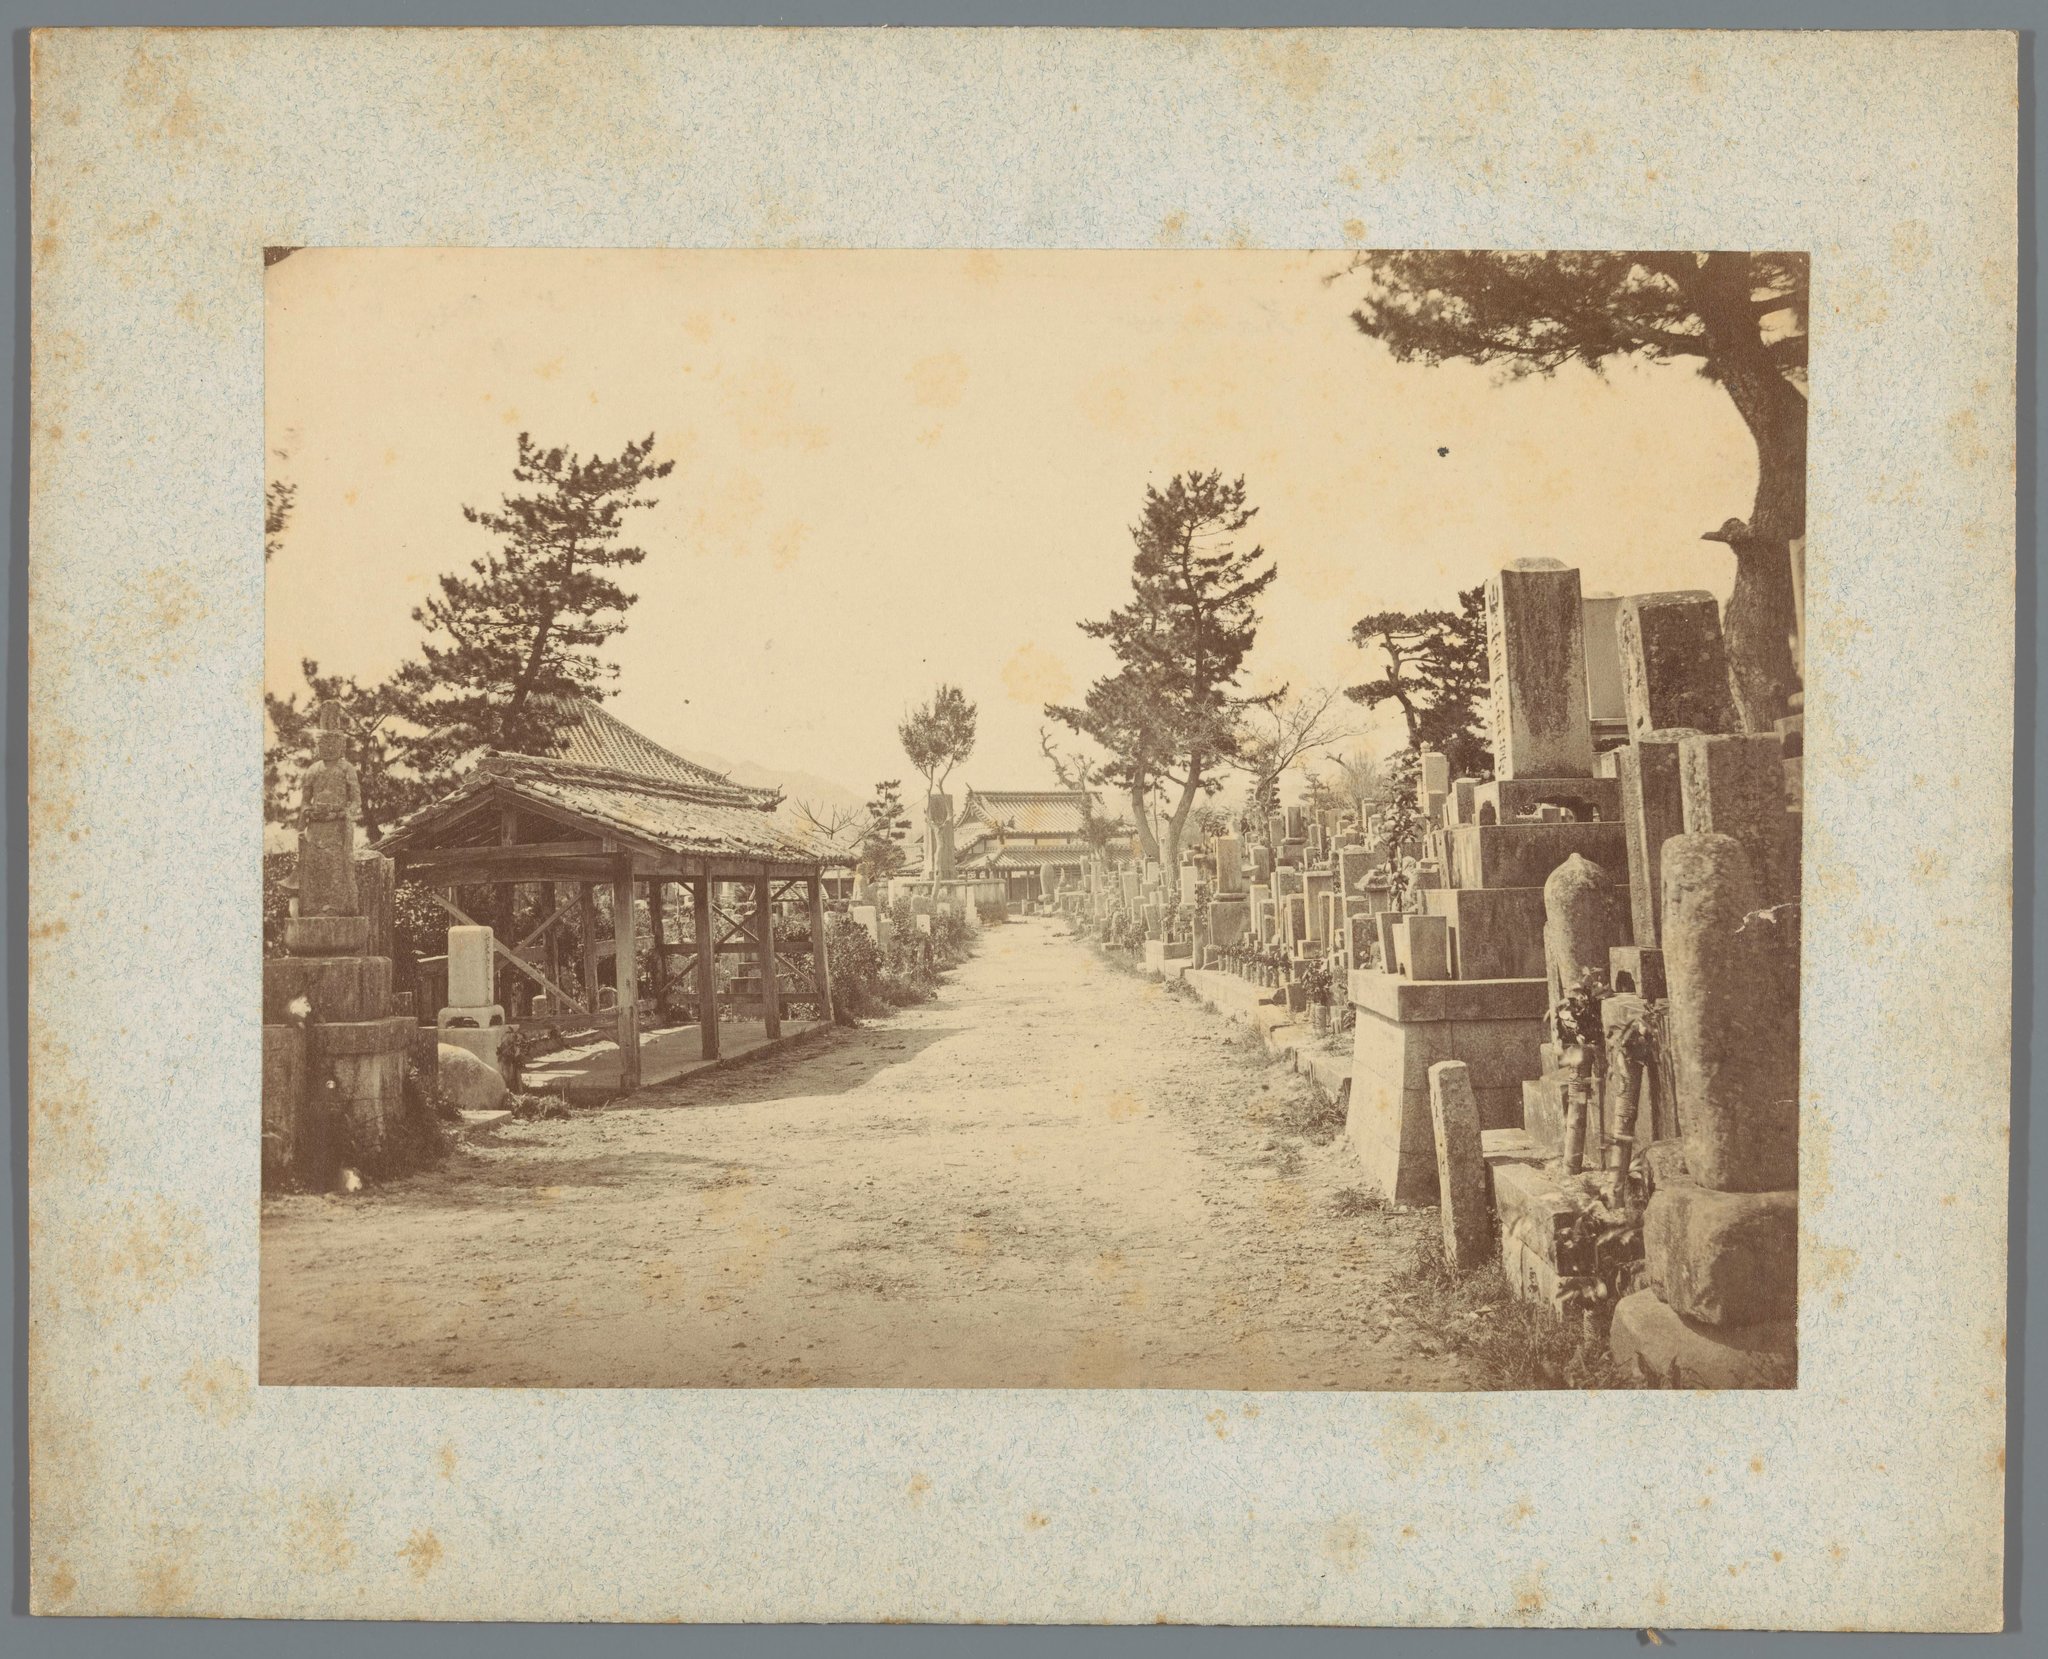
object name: photograph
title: Begraafplaats, vermoedelijk in Japan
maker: Anonymous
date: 1875-1900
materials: cardboard, photographic support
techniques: albumen print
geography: japan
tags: trees, column (marking grave), cemetery, park-like burying ground, japan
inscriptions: collector's mark: Lugt 3937